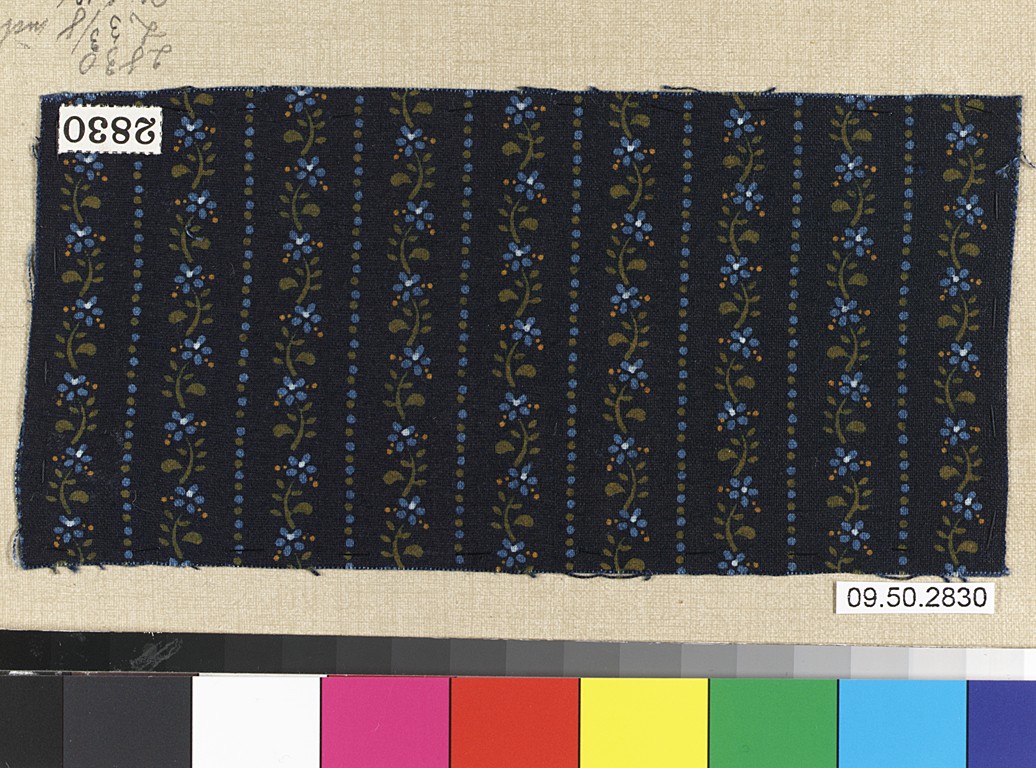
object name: piece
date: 1801-1900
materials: cotton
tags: flowers,leaves